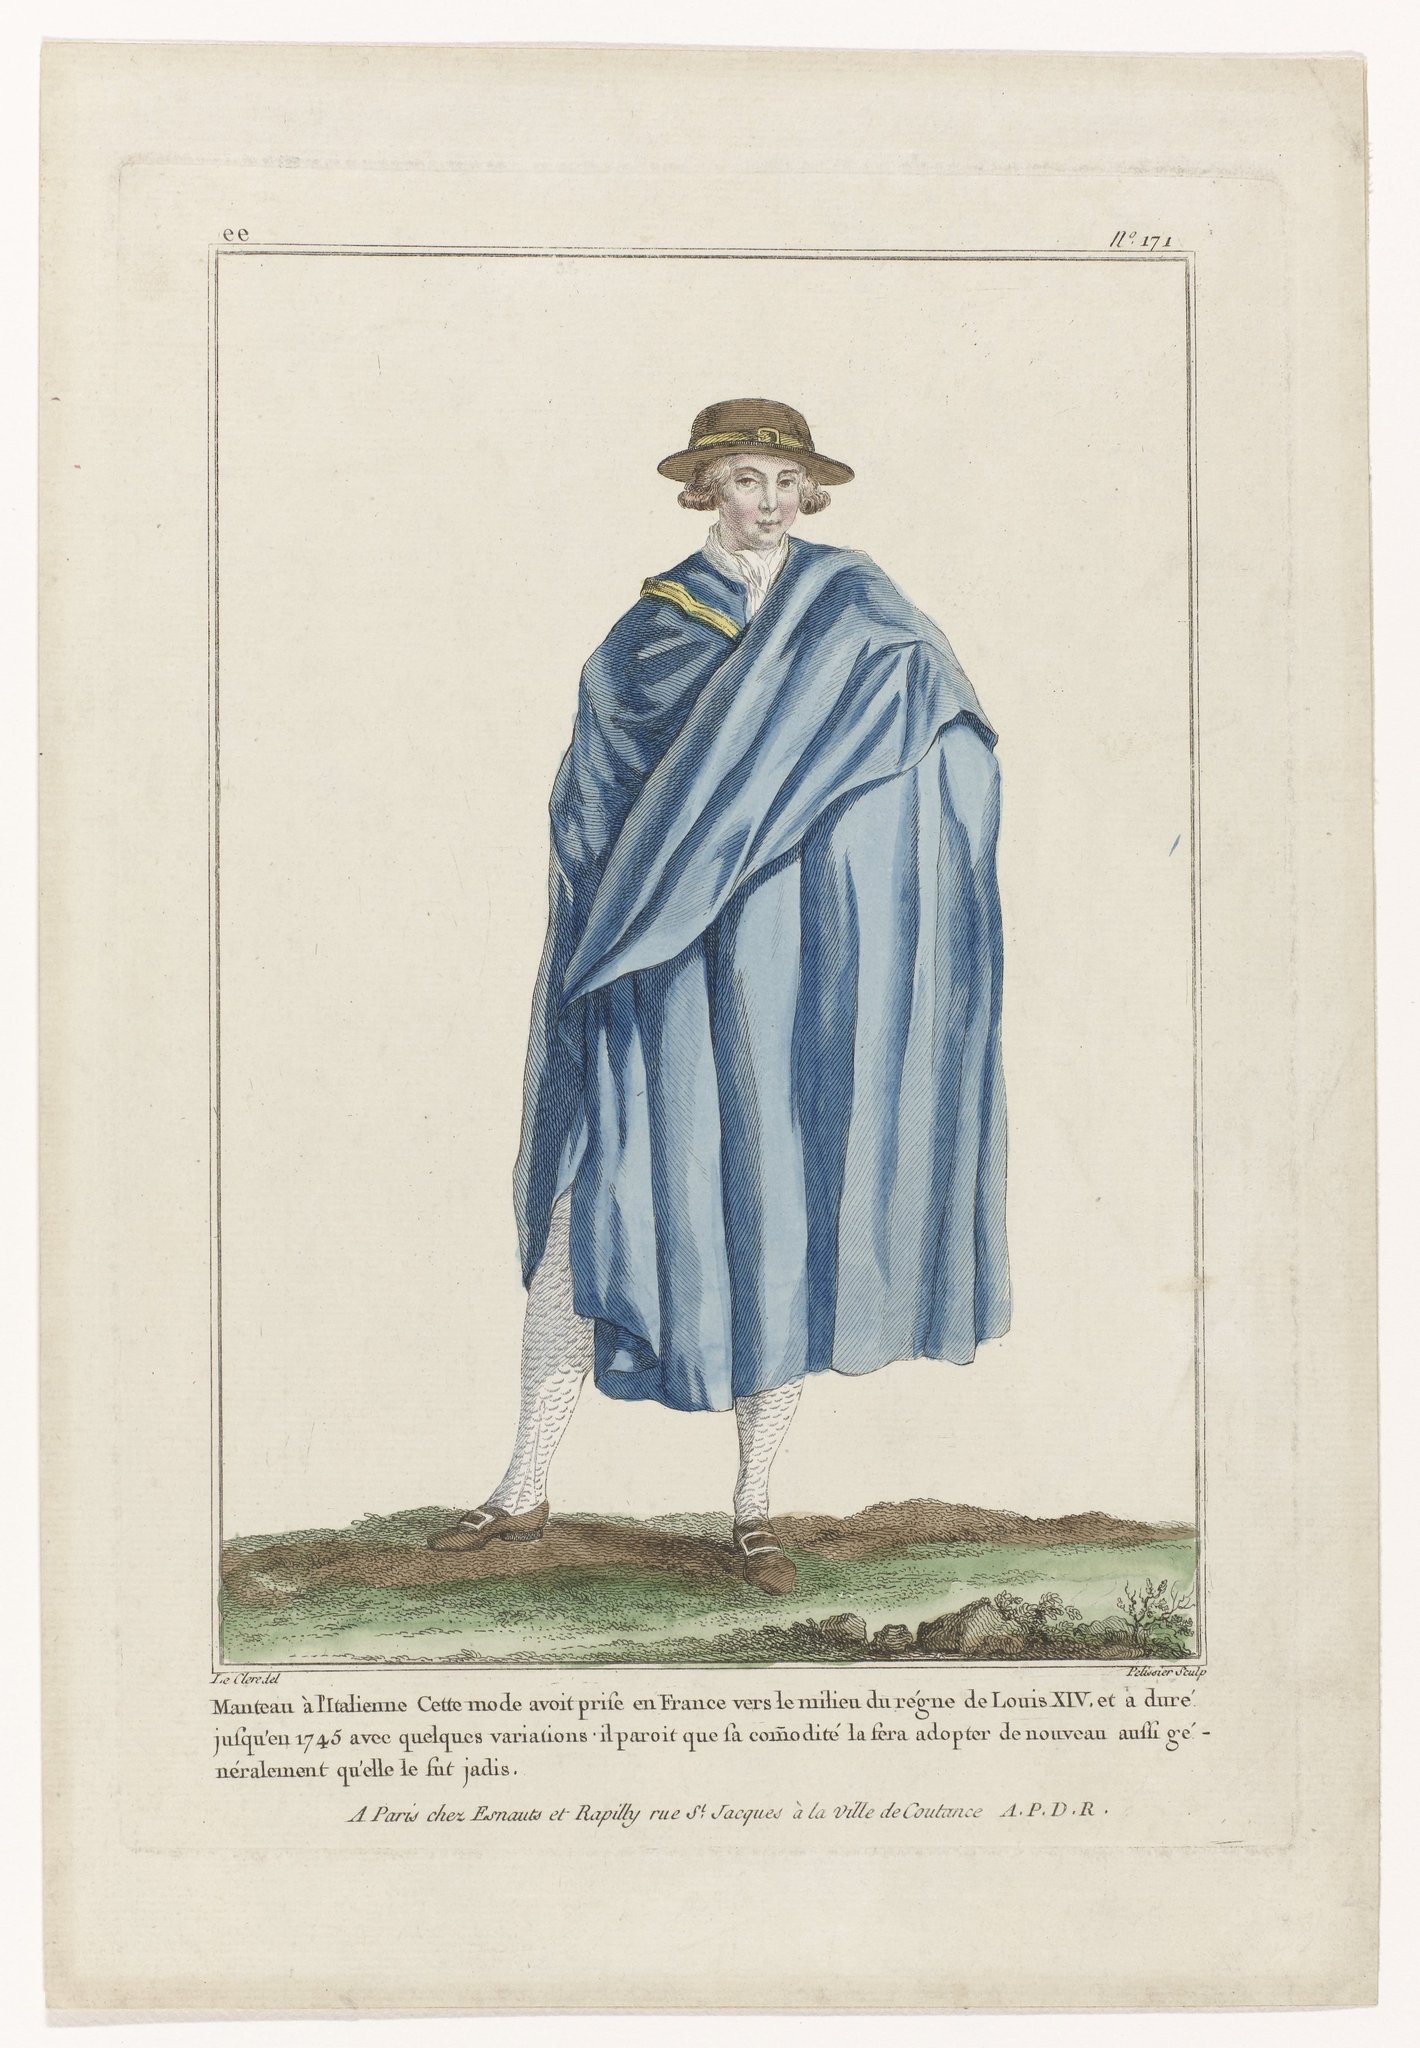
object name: fashion print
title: Gallerie des Modes et Costumes Français, 1780, ee 171 (bis) : Manteau à l'Italienn (...)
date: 1780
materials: paper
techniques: engraving, hand coloring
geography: paris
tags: neck-gear ~ clothing (neckerchief) (+ men's clothes), cape (+ men's clothes), cape (manteau à l'italienne) (+ men's clothes), head-gear: hat (+ men's clothes), fashion plates, shoes, sandals (+ men's clothes), stockings, socks (+ men's clothes)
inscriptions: address: ‘A Paris chez Esnauts et Rapilly, rue St. Jacques à la Ville de Coutances. A.P.D.R.’, caption: ‘Manteau à l'Italienne Cette mode avoit prise en France vers le milieu du régne de Louis XIV, et a duré jusqu'en 1745 quelques variations il paroit que sa comodité la sera adopter de nouveau aussi généralement qu'elle le sut jadis.’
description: Staande man gekleed in een 'manteau 'à l'Italienne'. Hoed met hoedenband en gesp, geknoopte halsdoek, kousen met golfmotief, schoenen met vierkante gespen. Het onderschrift meldt dat deze mantel in het midden van de regeringsperiode van Lodewijk XIV, tot 1745, in vele variaties, in de mode was. Het draaggemak is waarschijnlijk de oorzaak van de herlevende mode in 1780. Prent uit de serie ee. 29e Cahier de Costumes Français bis Pour servir de Supplément à la 7e suite d'habillements à la mode en 1780, Gallerie des Modes et Costumes Français.